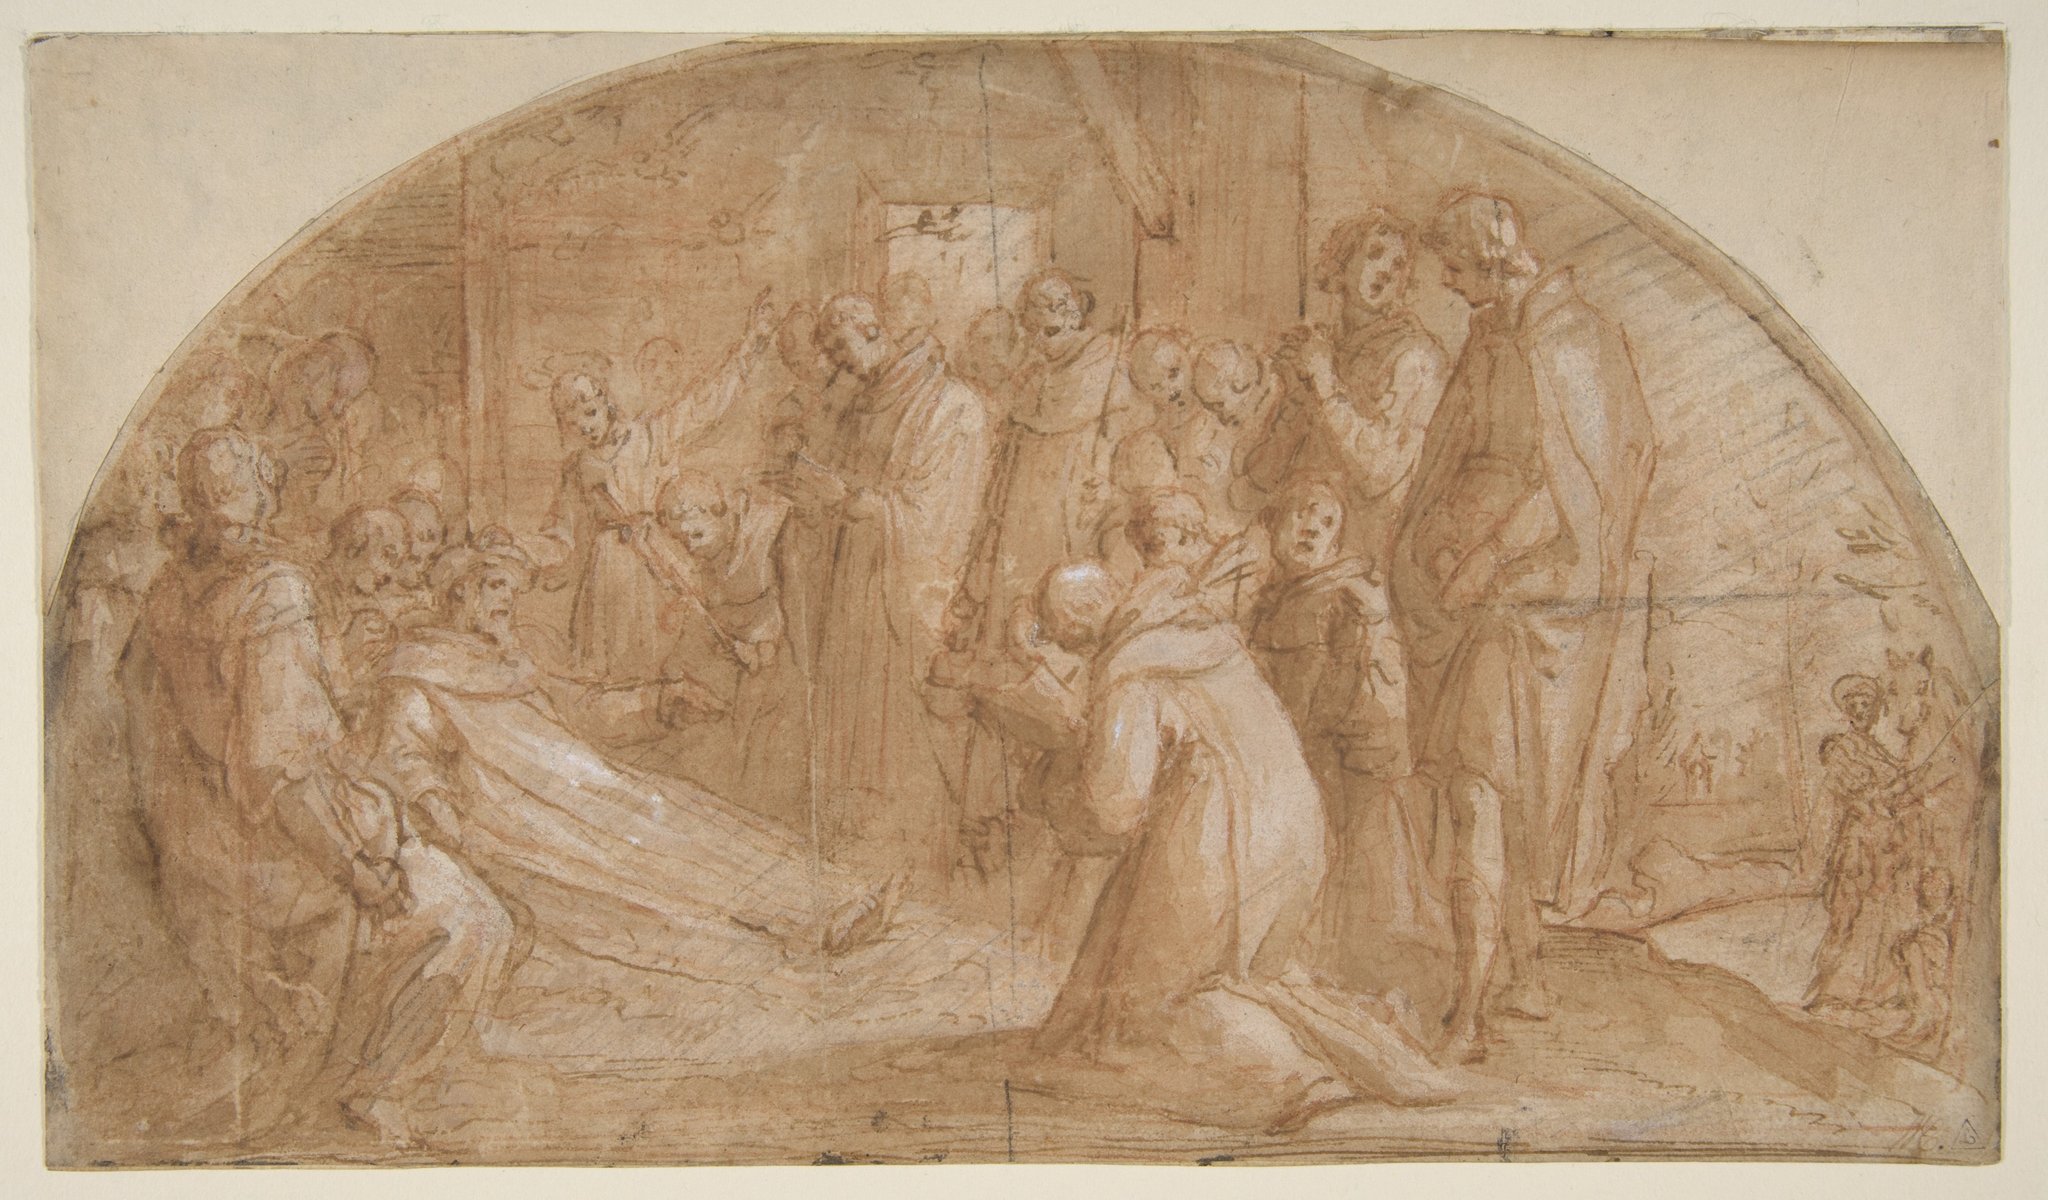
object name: drawing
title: The death of Saint Alexis Falconieri at Monte Senario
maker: bernardino poccetti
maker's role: artist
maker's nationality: italian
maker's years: 1548-1612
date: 1548-1612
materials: chalk, charcoal, ink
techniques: brush, highlighting, pen, wash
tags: men,women,saints,death